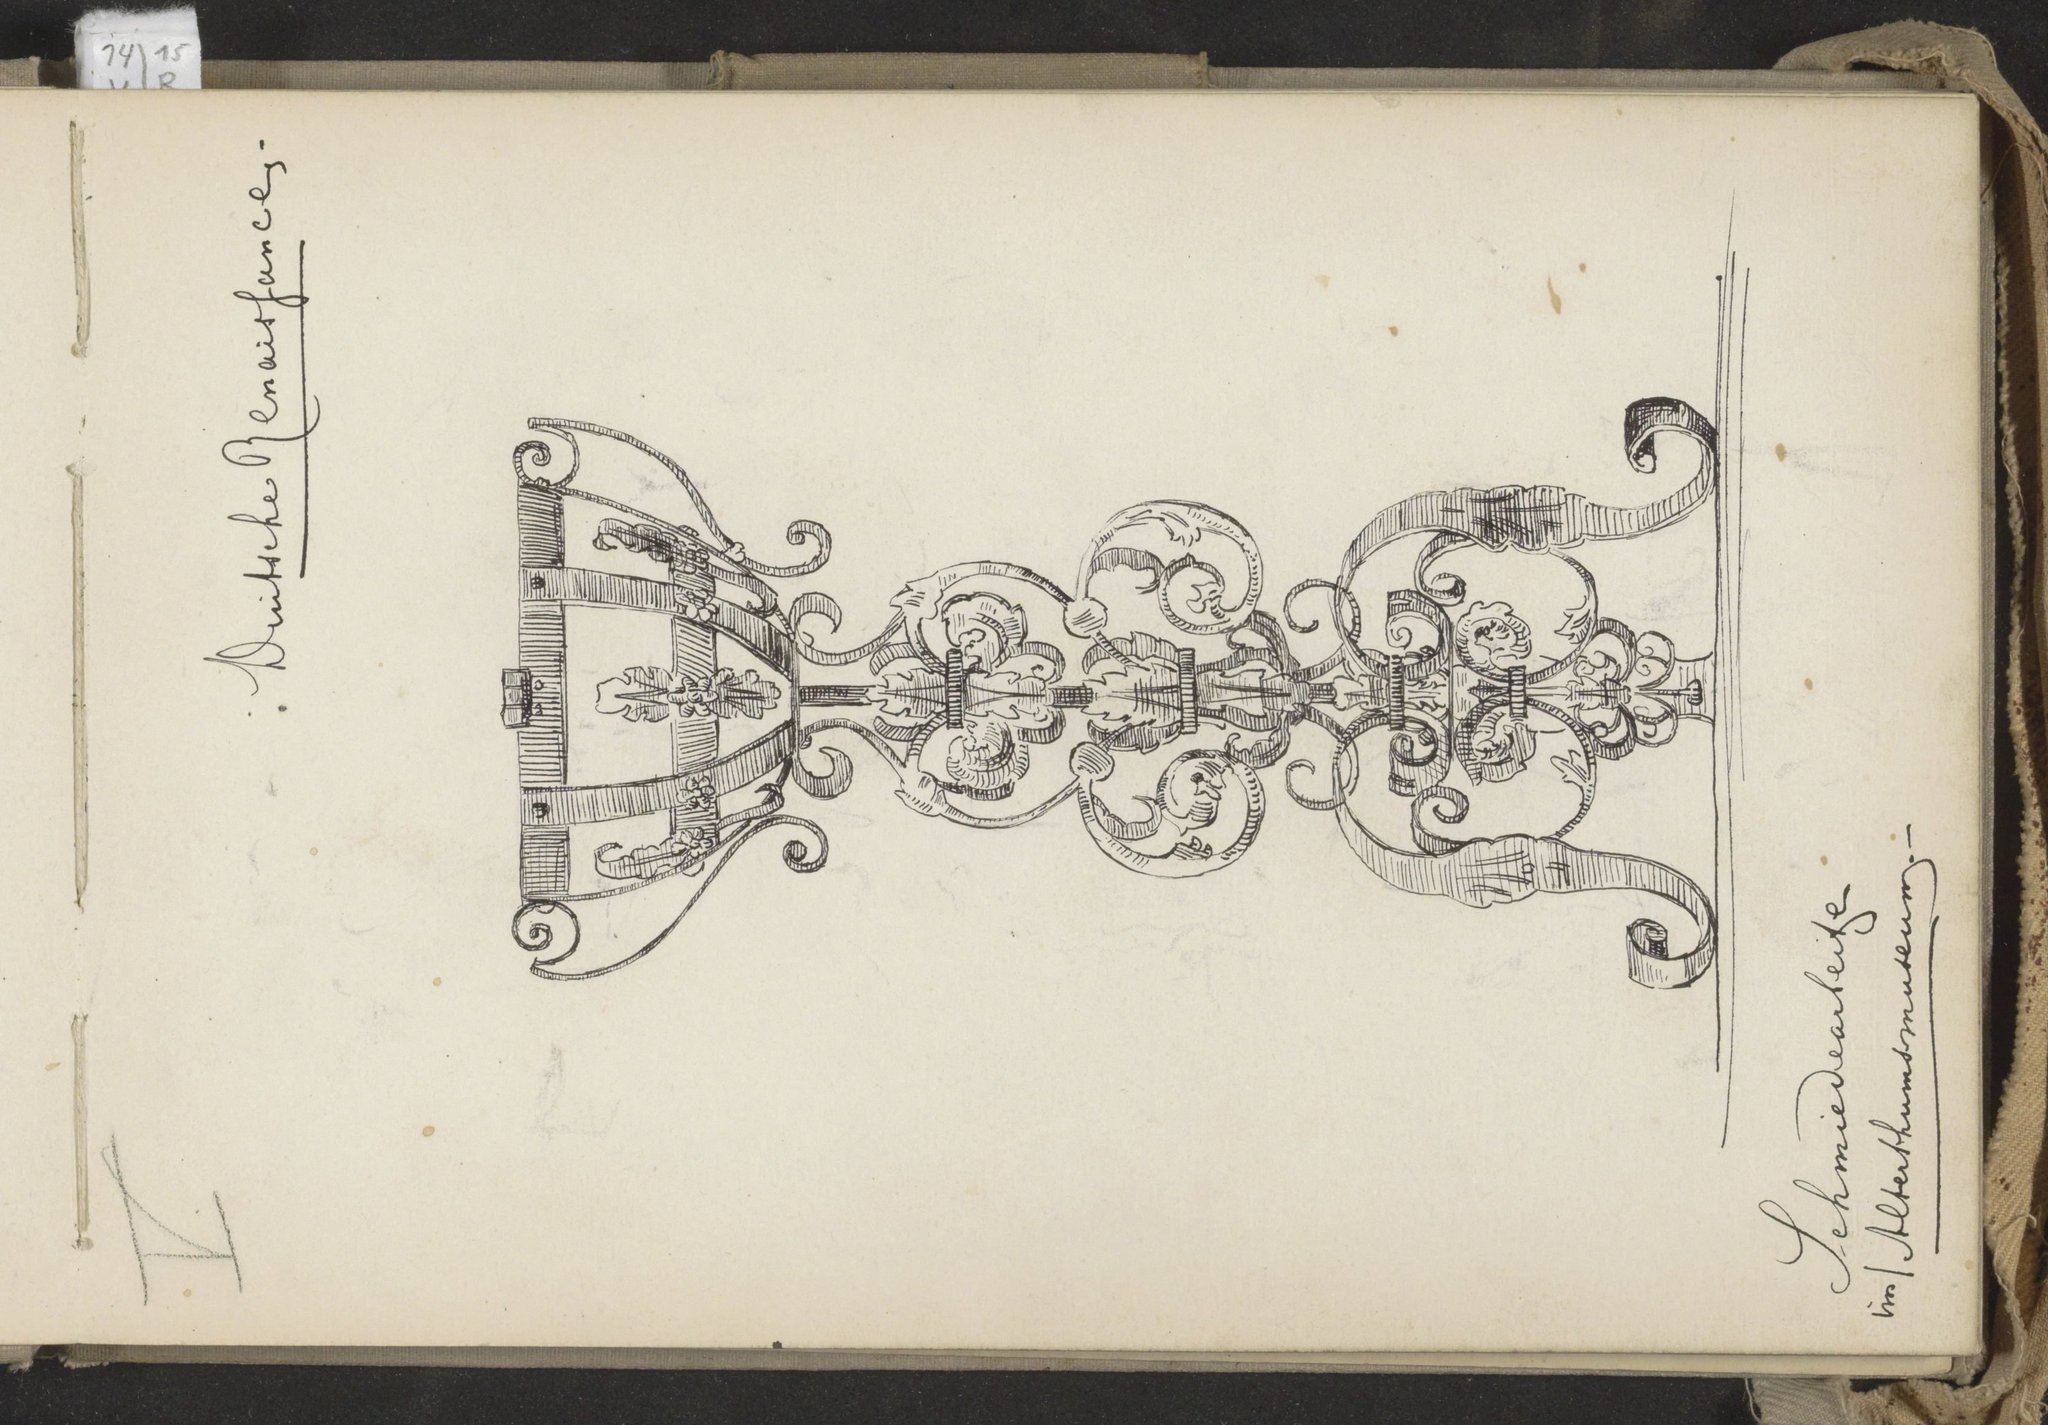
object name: sketchbook leaf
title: Smeedijzeren kelk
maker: johanna van de kamer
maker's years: 1873-1922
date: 1890-1922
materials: ink, paper, pencil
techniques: pen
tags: chalice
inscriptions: number: ‘V’, annotation: ‘Duitsche Renaissance./ Schoedearbeite/ im/ Alterhu[...]smuseum.-’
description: Blad 12 recto uit een schetsboek met 49 bladen.